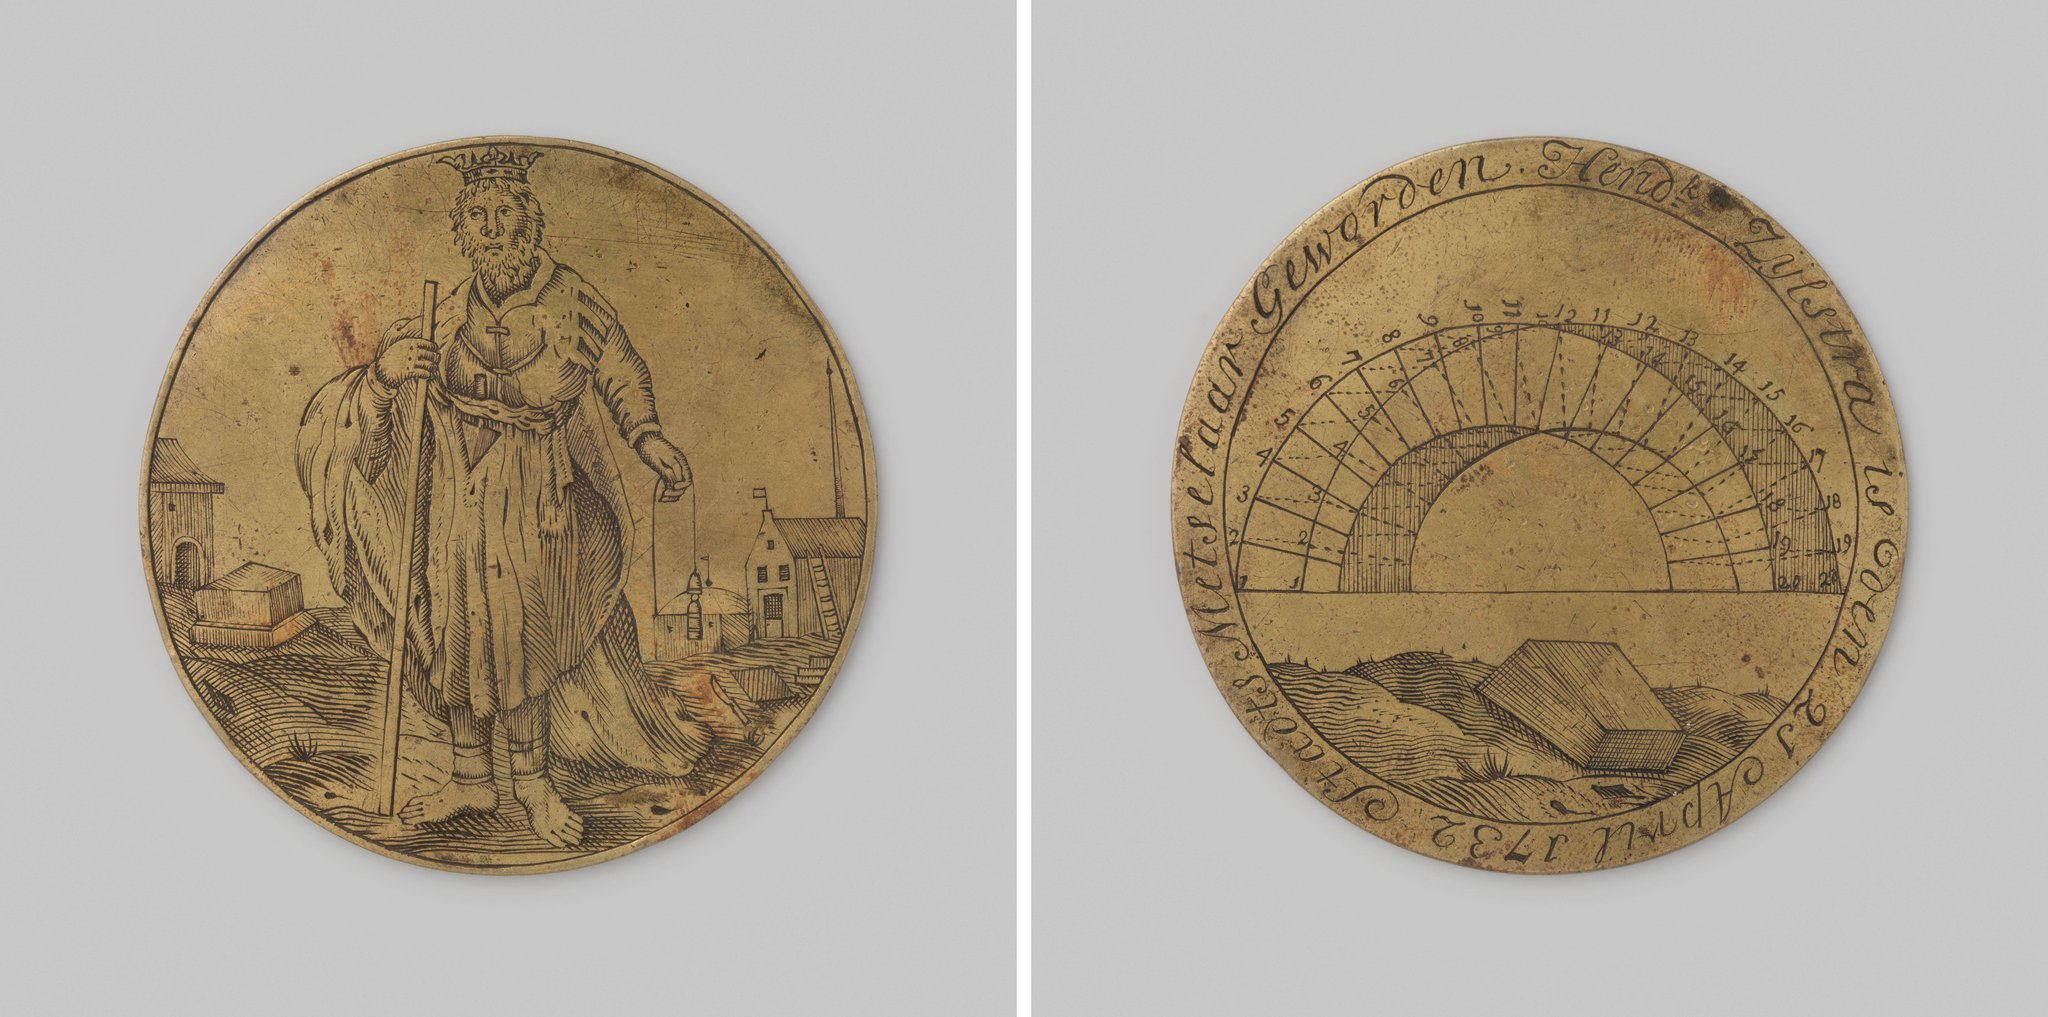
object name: history medal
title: Hendrik Zijlstra benoemd tot stadsmetselaar te Leeuwarden 1732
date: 1732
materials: brass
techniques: engraving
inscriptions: circumscription: ‘Hend'k Zijlstra is den 21 April 1732 Stadts Metselaar Geworden.’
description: Tweezijdig gegraveerde ronde plaat messing, op de voorzijde een gekroonde schutspatroon met staf en schietlood, in een landschap met bouwwerken, op de keerzijde een landschap waarboven de bouwtekening van een ronde boog, met omschrift.